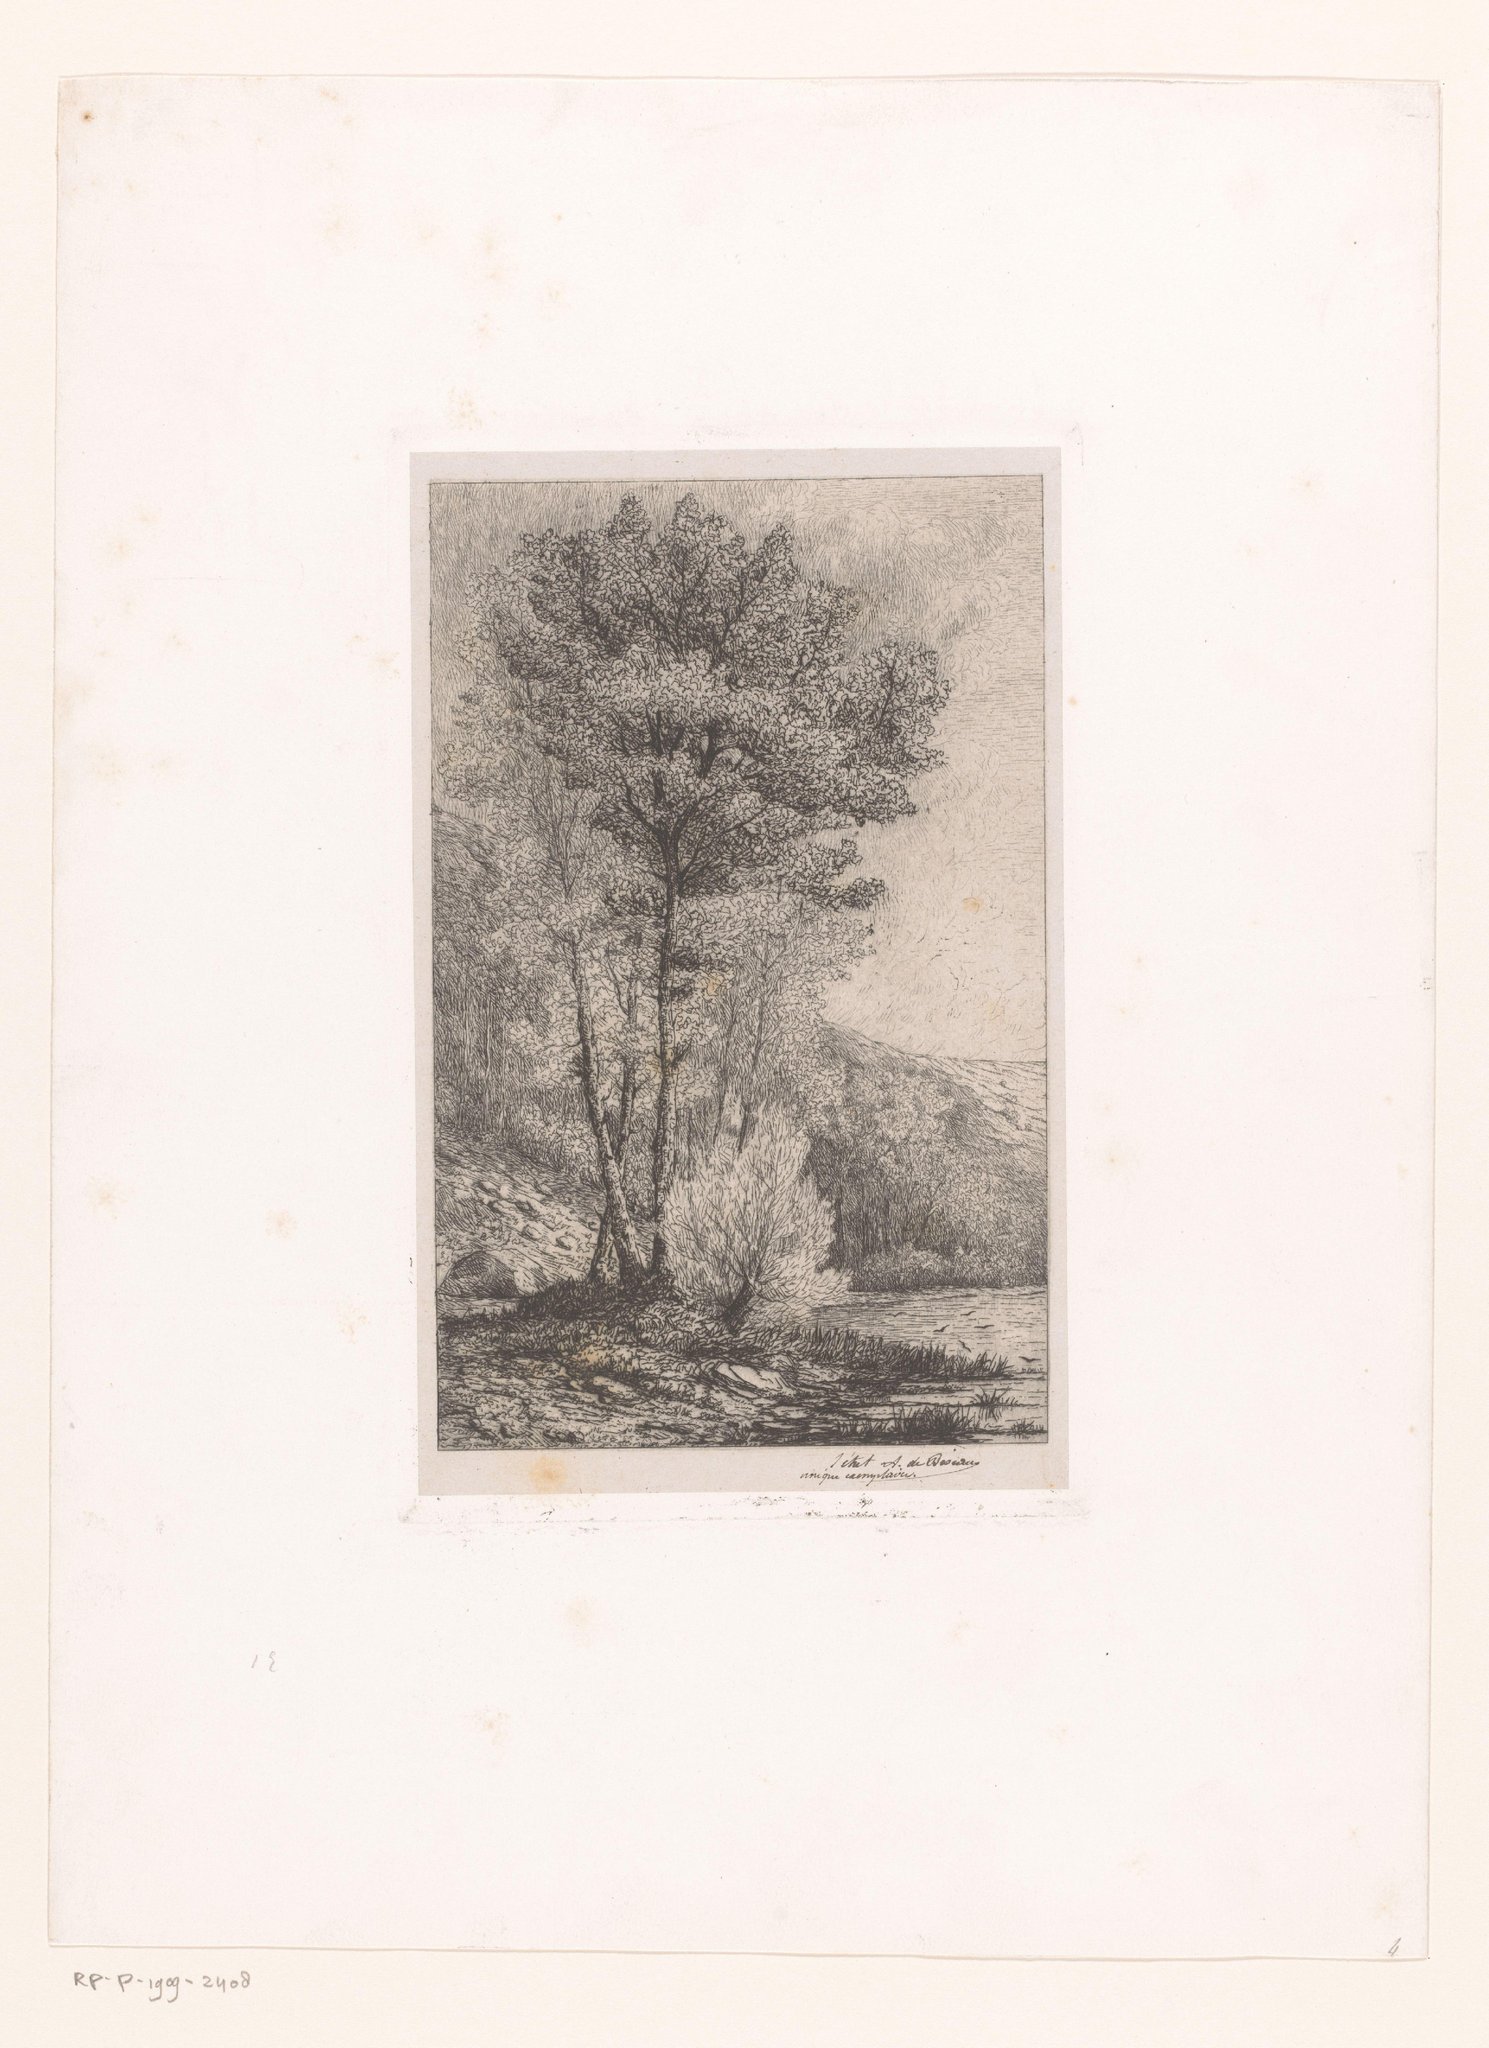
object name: print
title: Hoge bomen aan een meer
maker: aristide de biseau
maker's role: print maker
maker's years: 1844-1883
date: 1854-1883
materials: paper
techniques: etching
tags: trees, lake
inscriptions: collector's mark: Lugt 2228, inscription: ‘1 etat unique exemplaire’